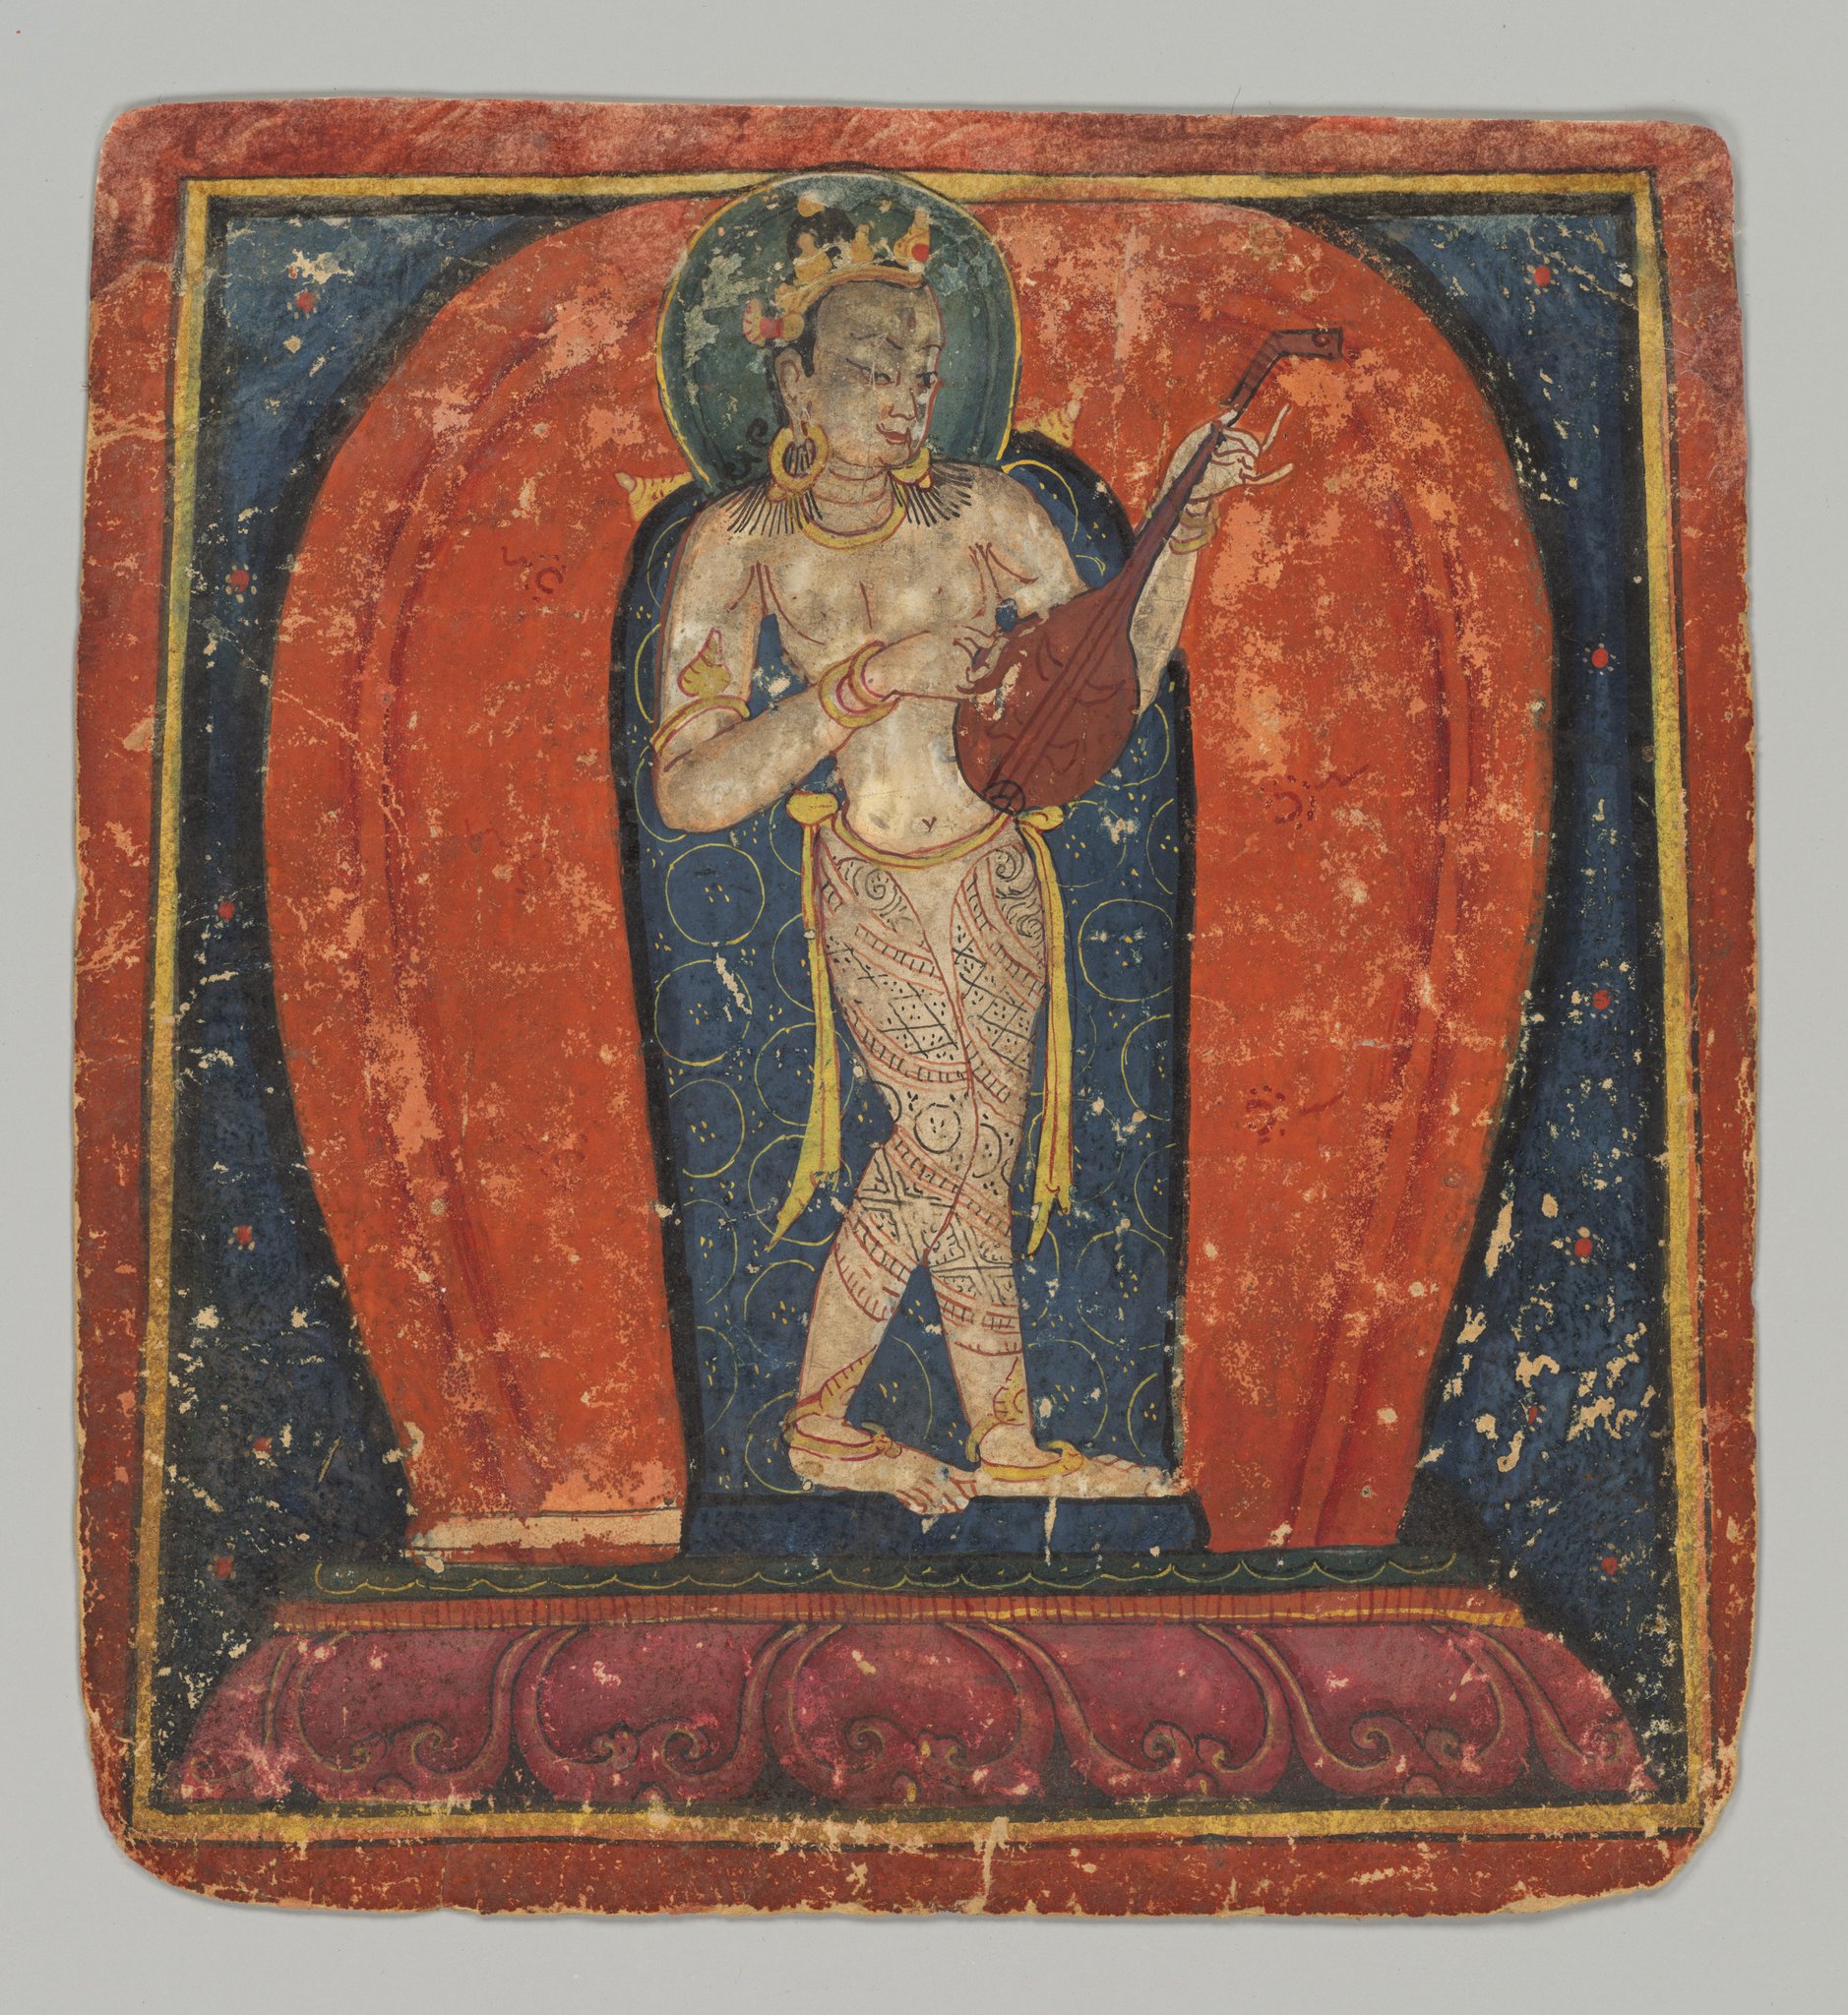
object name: initiation card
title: Iniation Card (Tsakalis)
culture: tibetan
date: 1401-1433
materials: paper, watercolor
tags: musical instruments,buddhism